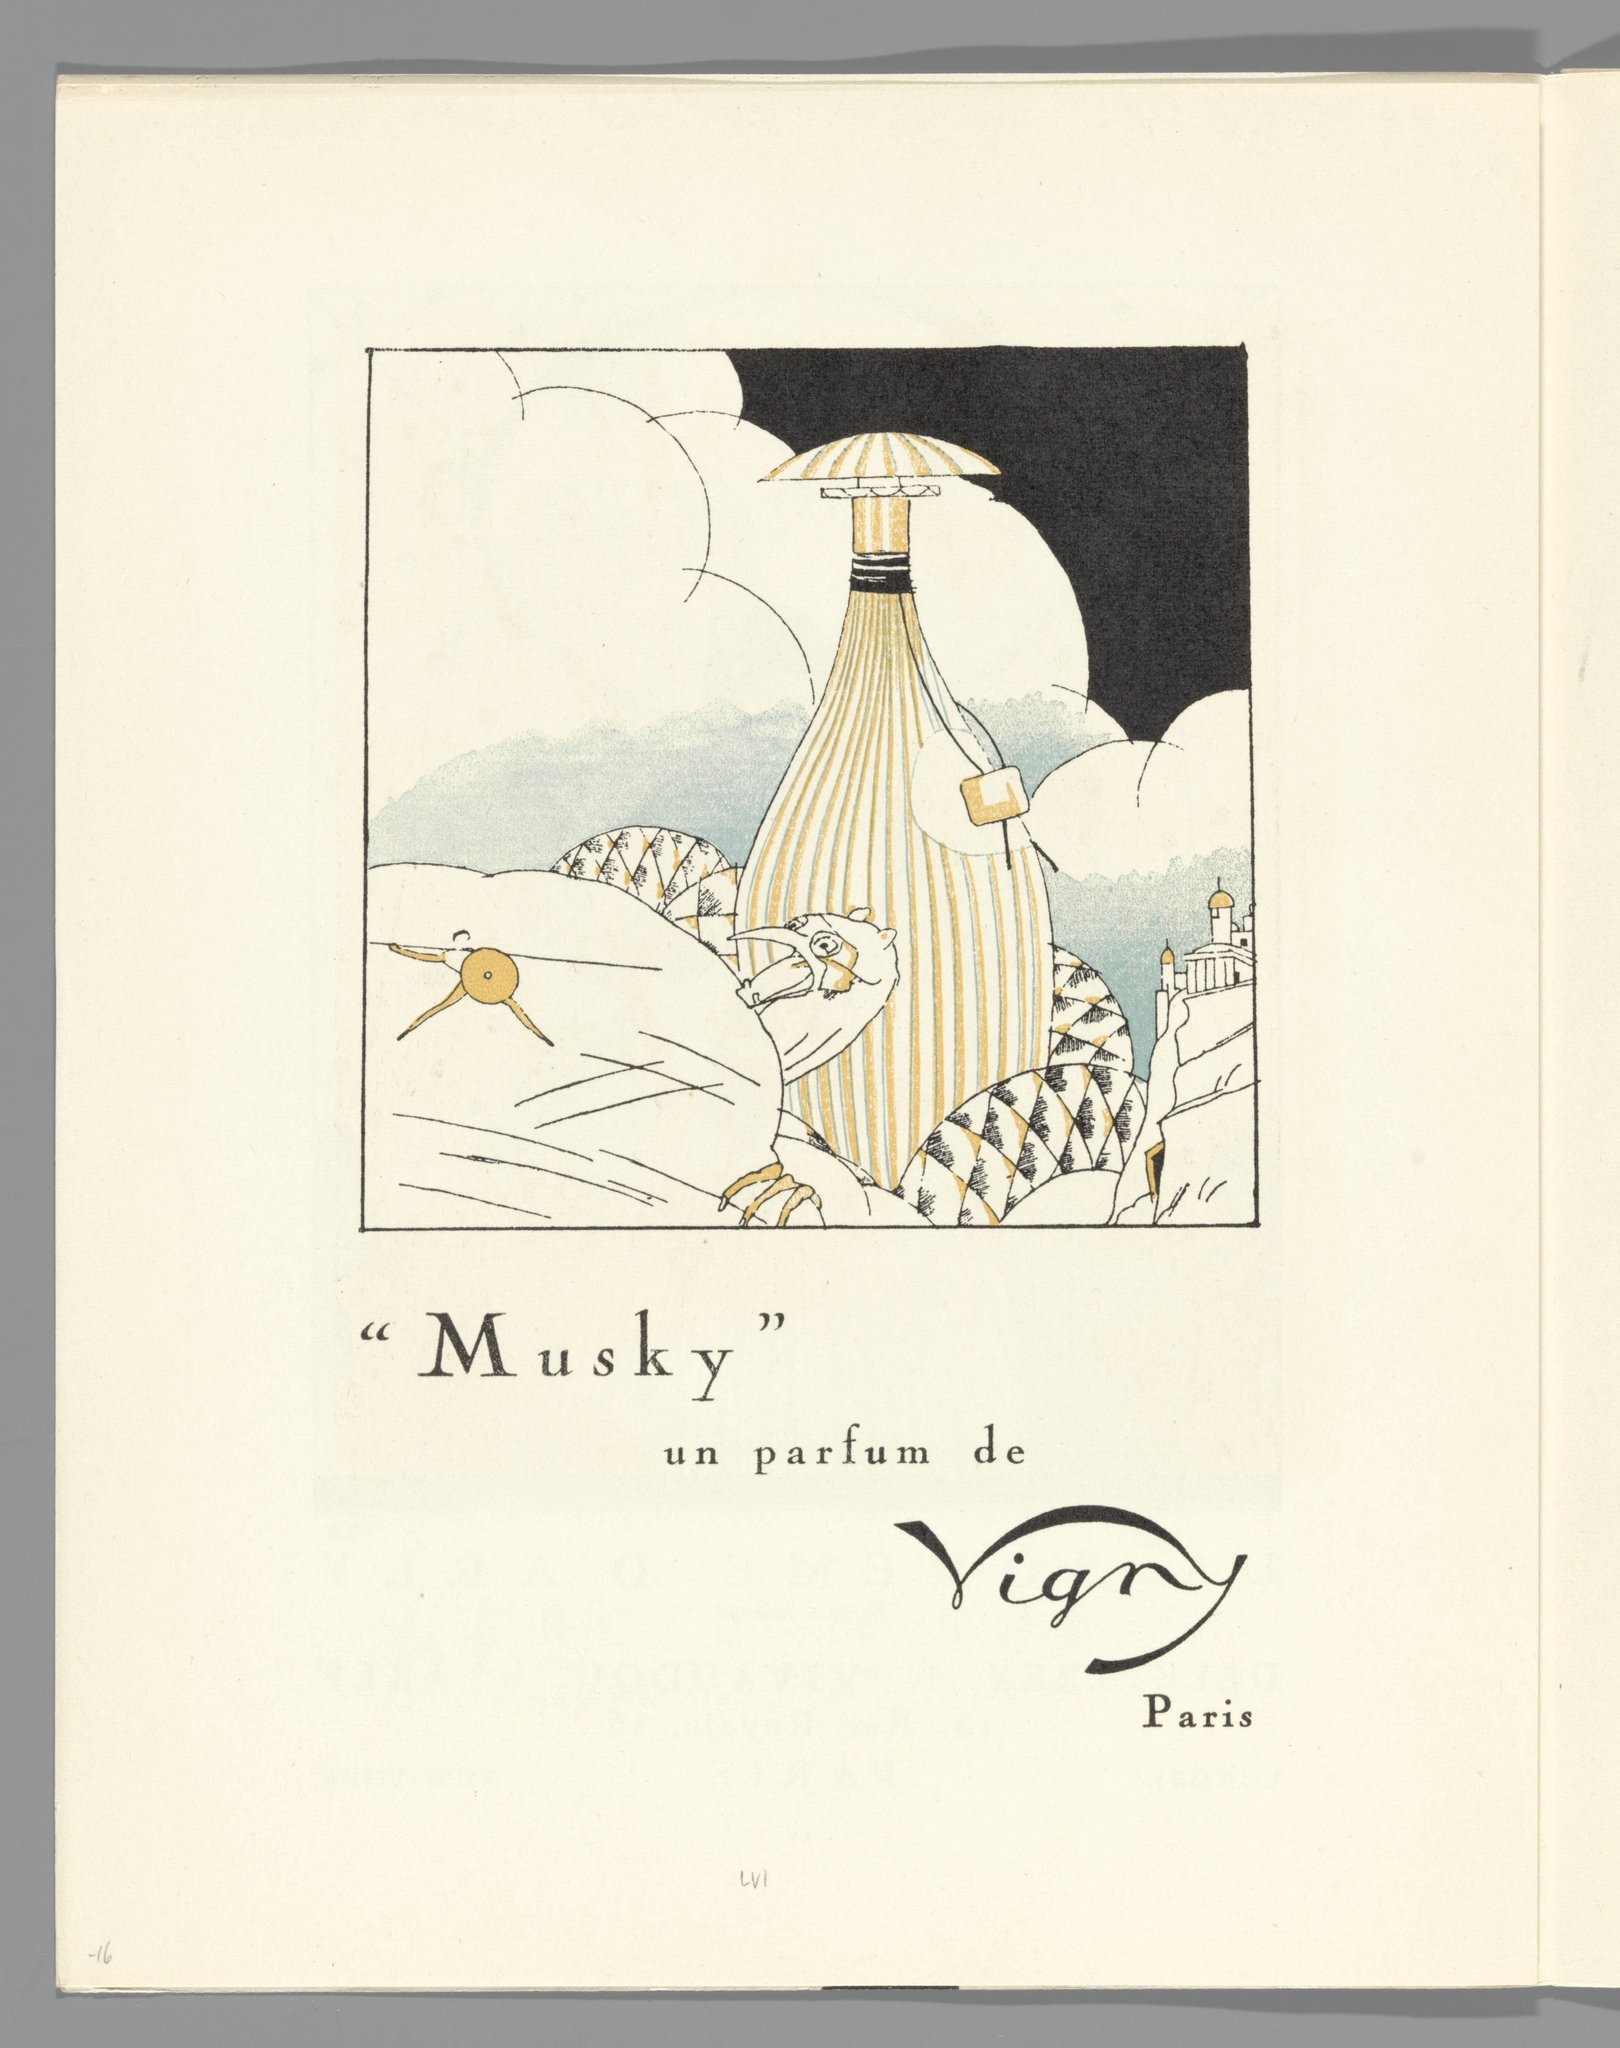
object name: fashion print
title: Gazette du Bon Ton. Art – Modes & Frivolités: Advertising Material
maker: lucien vogel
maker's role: publisher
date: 1920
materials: paper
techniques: lithograph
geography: paris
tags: perfume bottle - aa - (for) women, fashion plates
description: The Gazette du Bon Ton also included advertisements: for shops selling fashions and fabrics, jewellers, hairdressers and beauticians. These ads were also well designed; many were drawn by the same artists who supplied the fashion plates. Even the smallest ads were presented with flair and in a style that was befitting of the whole.